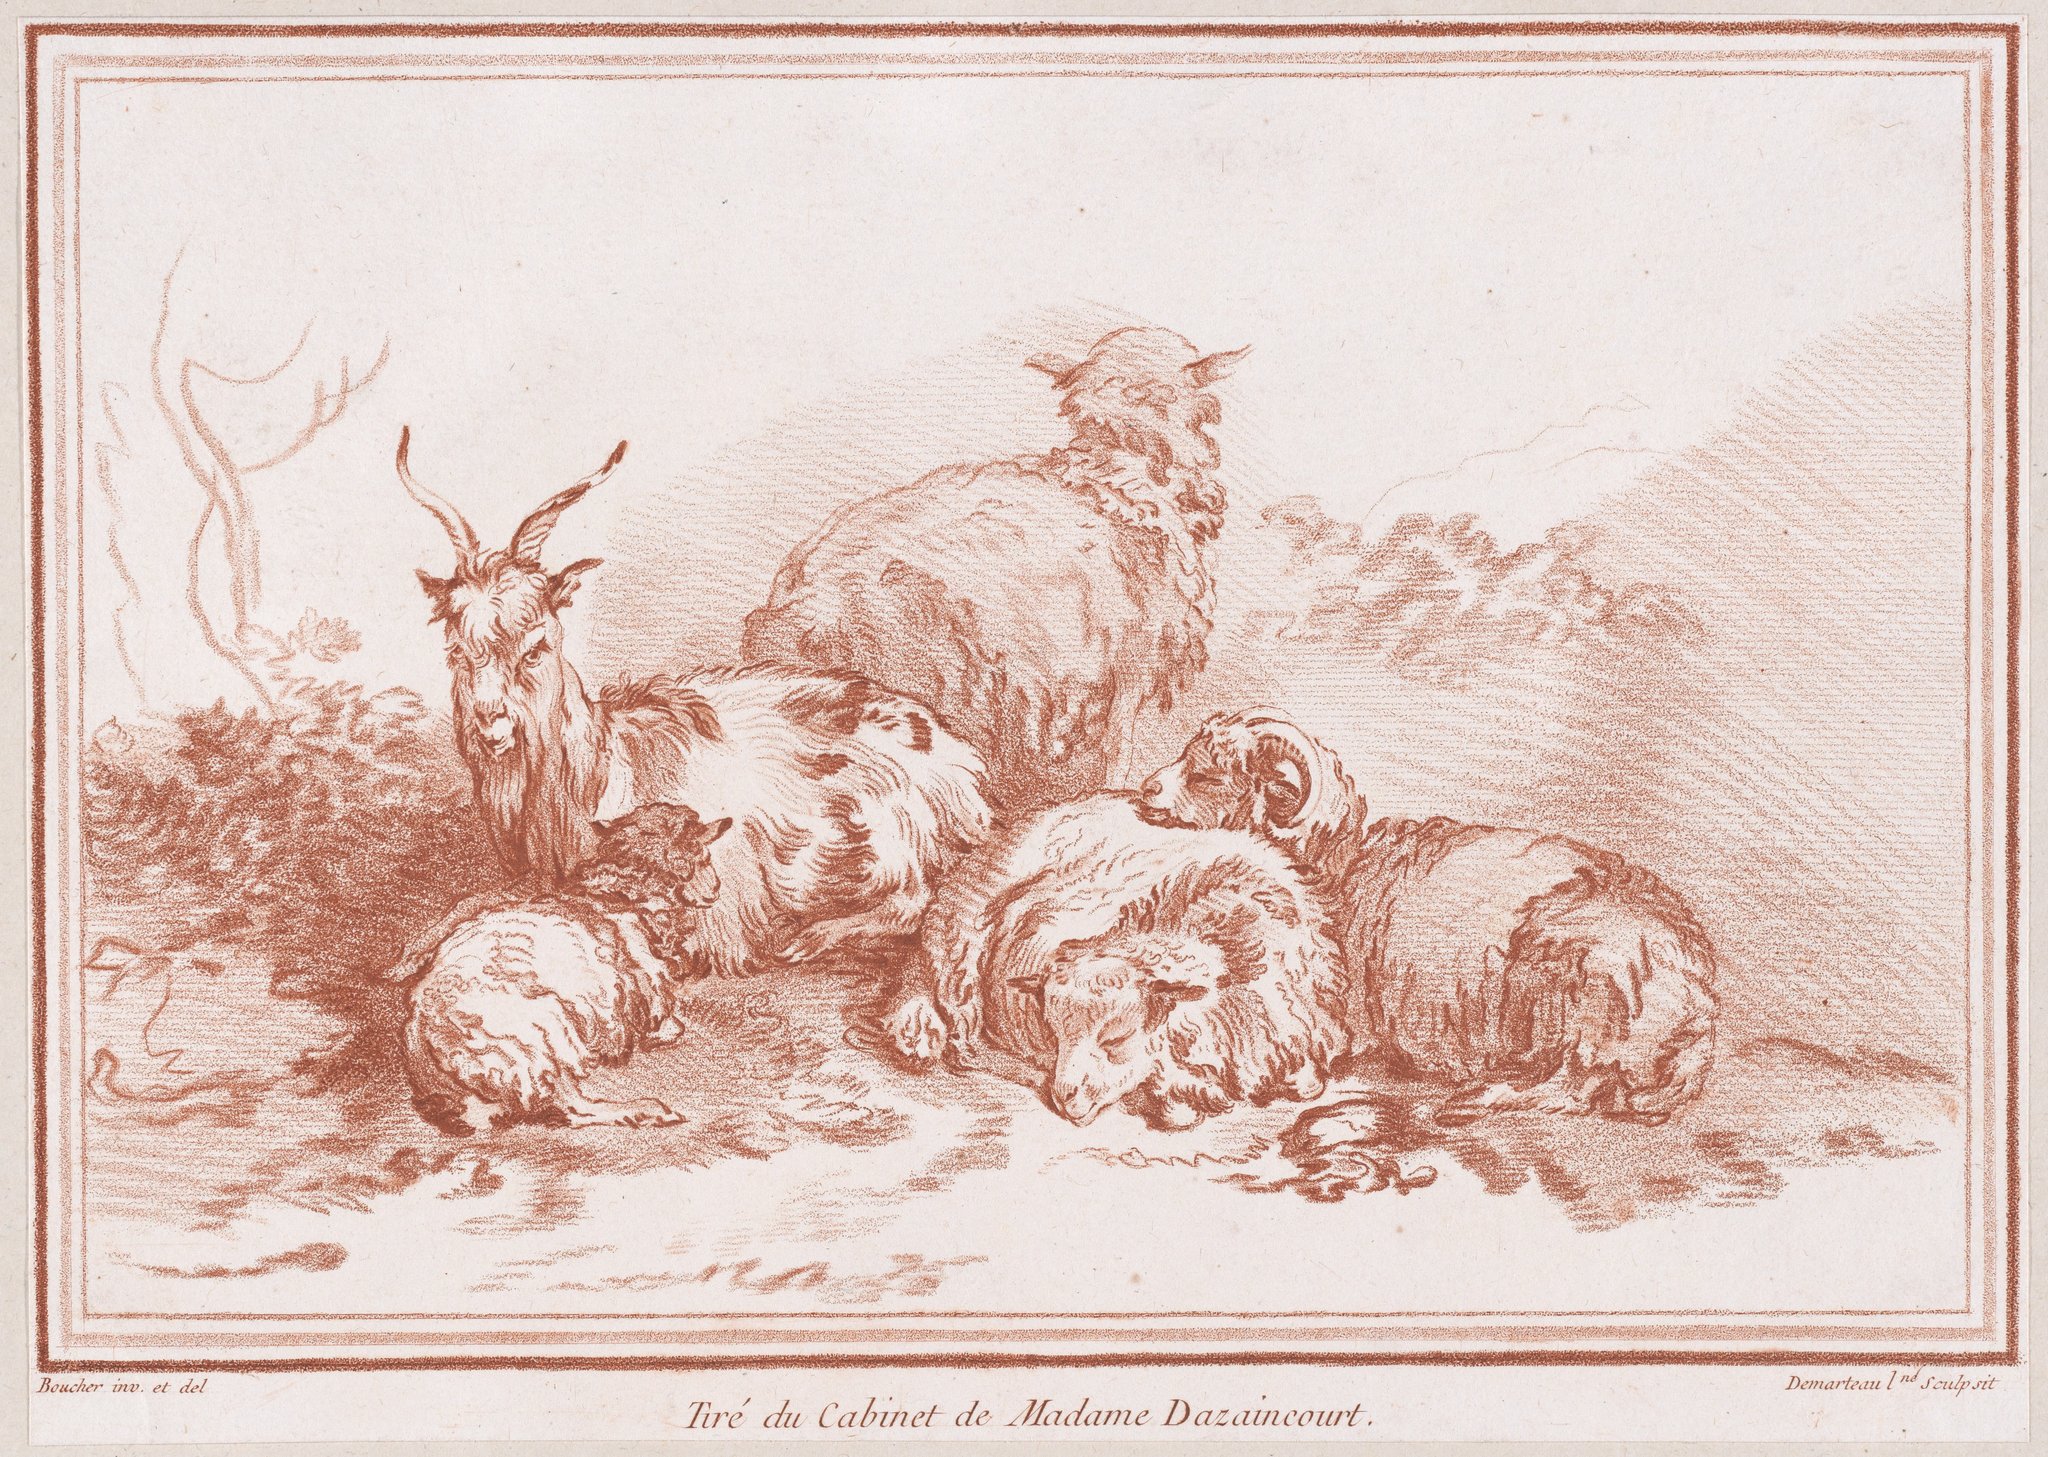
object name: print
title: Une chèvre et quatre moutons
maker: gilles demarteau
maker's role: artist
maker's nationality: french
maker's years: 1722-1776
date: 1701-1800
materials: ink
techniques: printmaking, etching, printing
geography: france